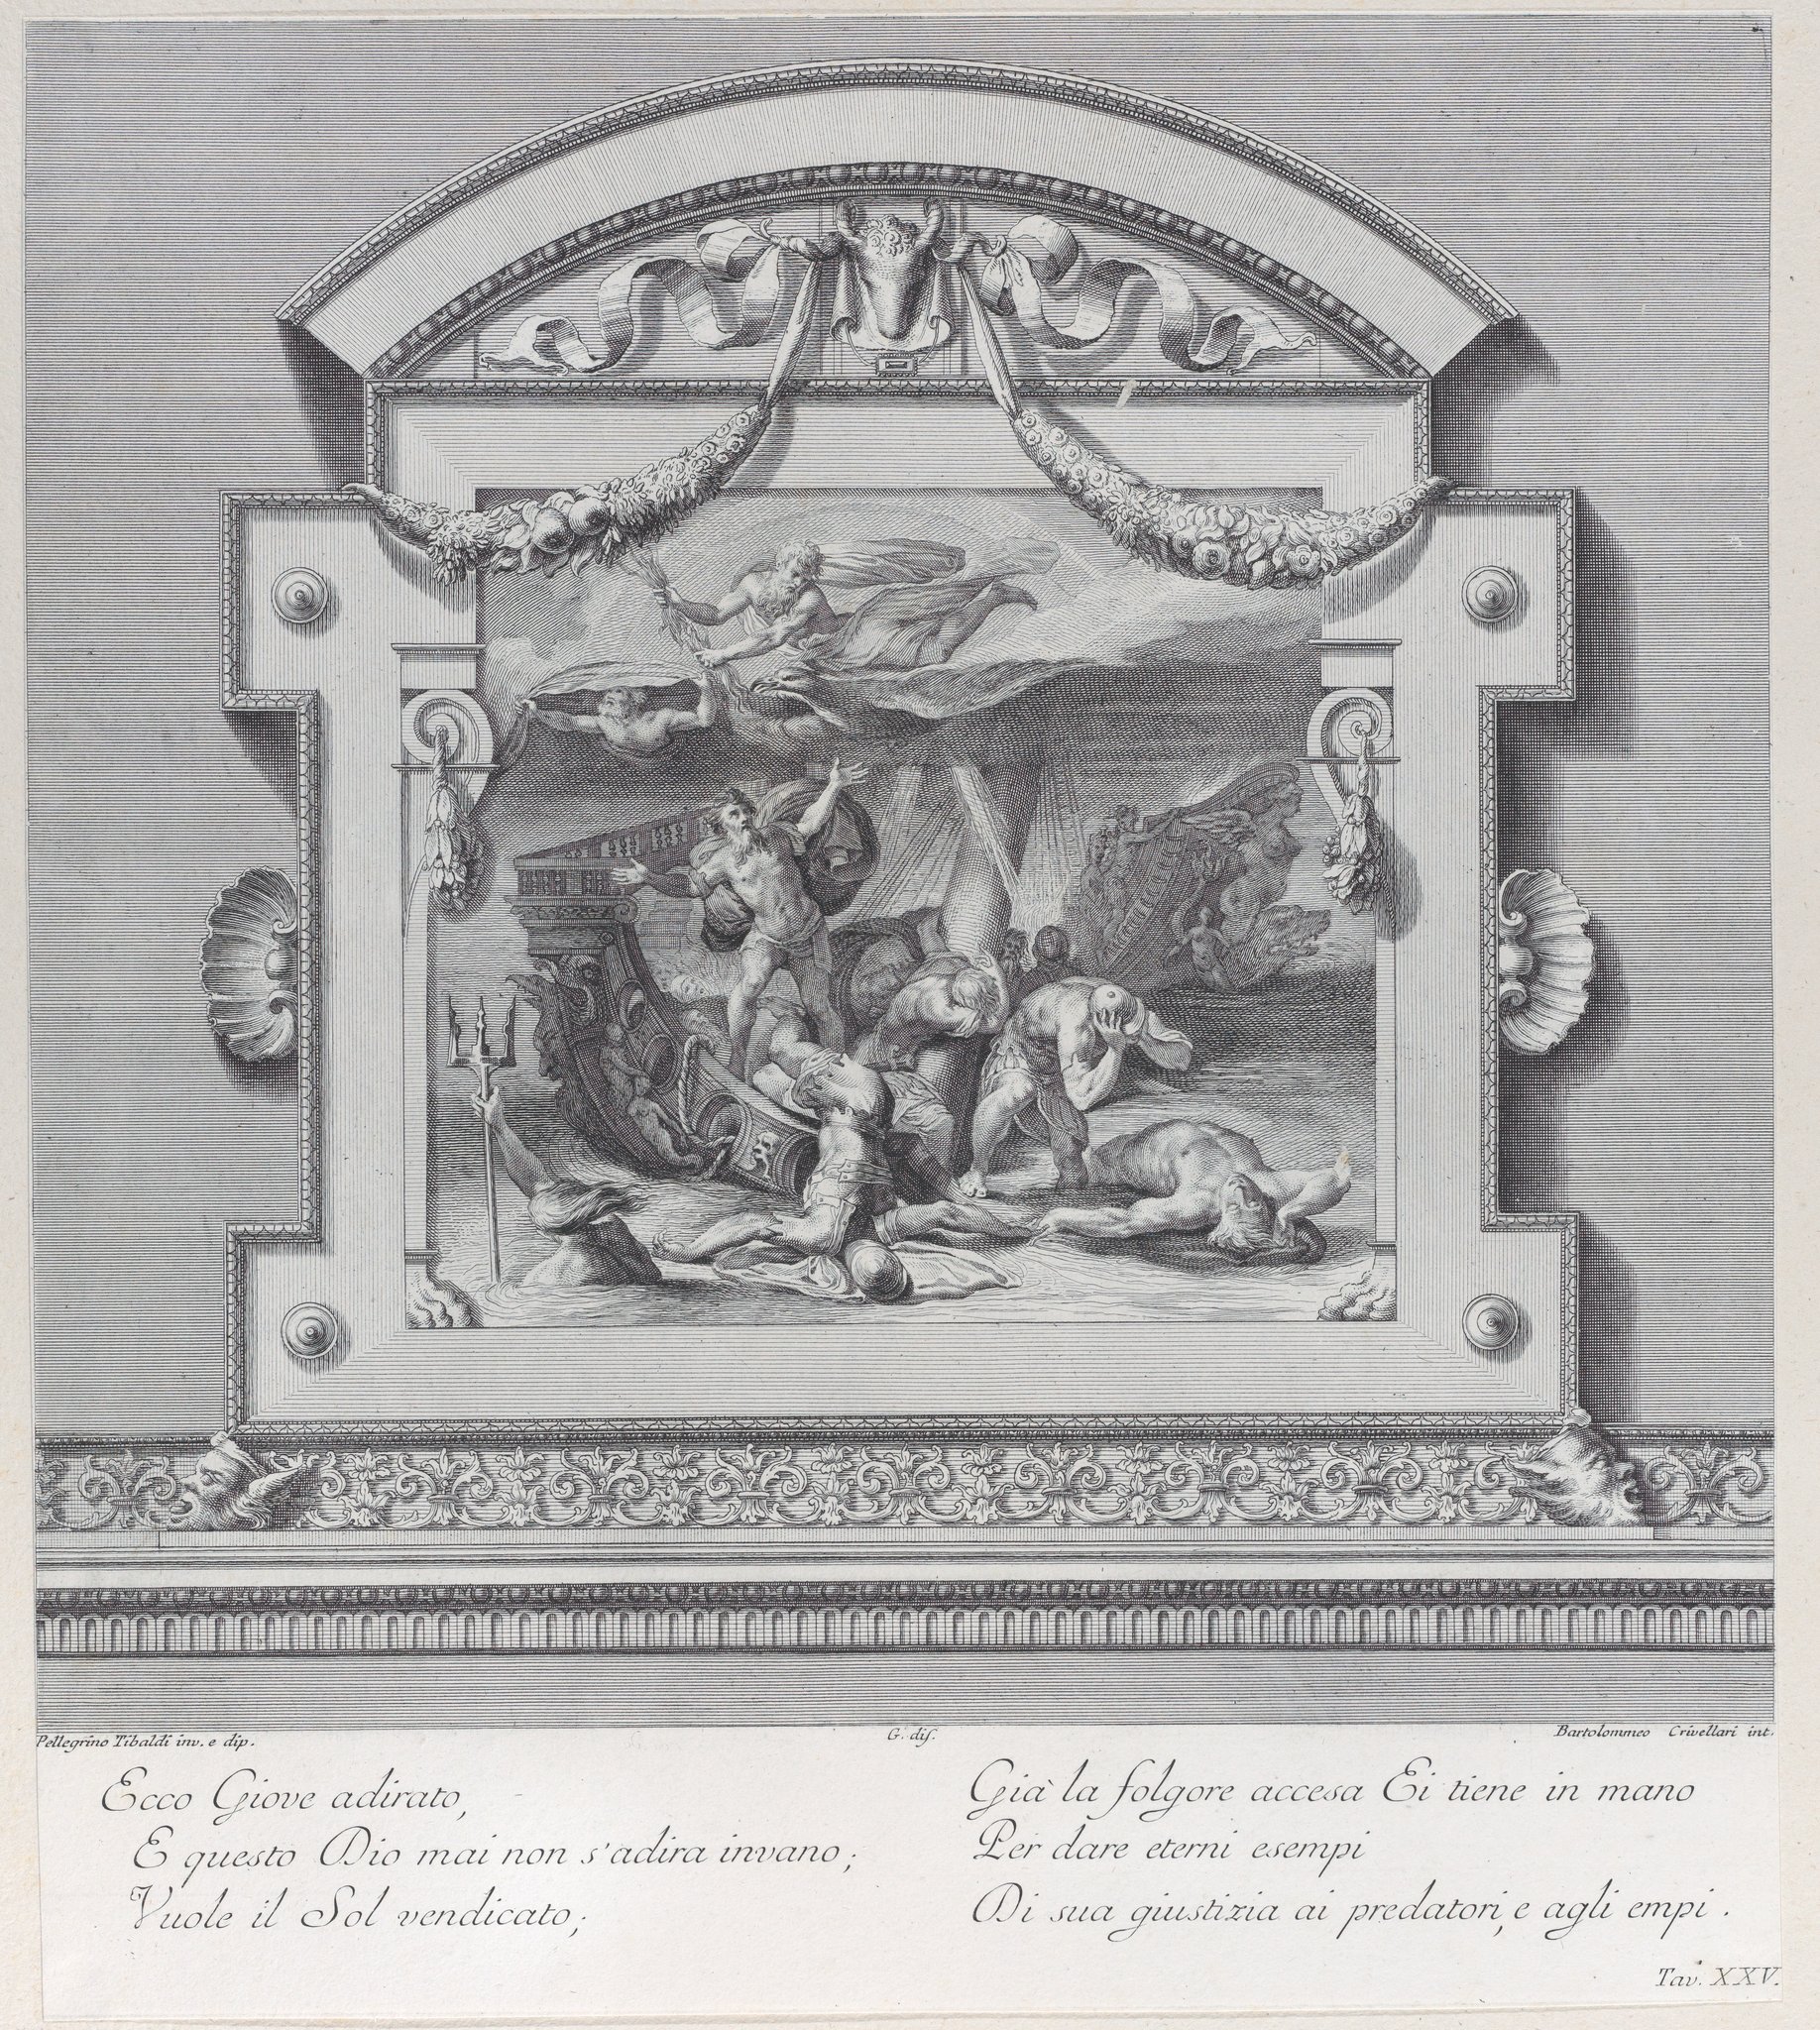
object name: print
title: Plate 25: a shipwreck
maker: bartolomeo crivellari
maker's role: artist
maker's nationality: italian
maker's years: 1700-1800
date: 1756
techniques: engraving, etching